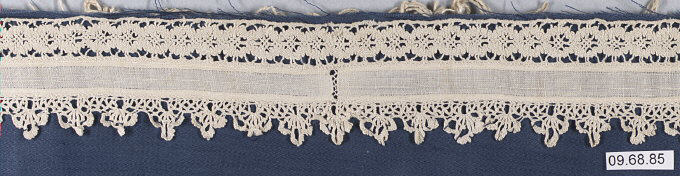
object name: edging and insertion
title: Insertion and edging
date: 1601-1700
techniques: lace